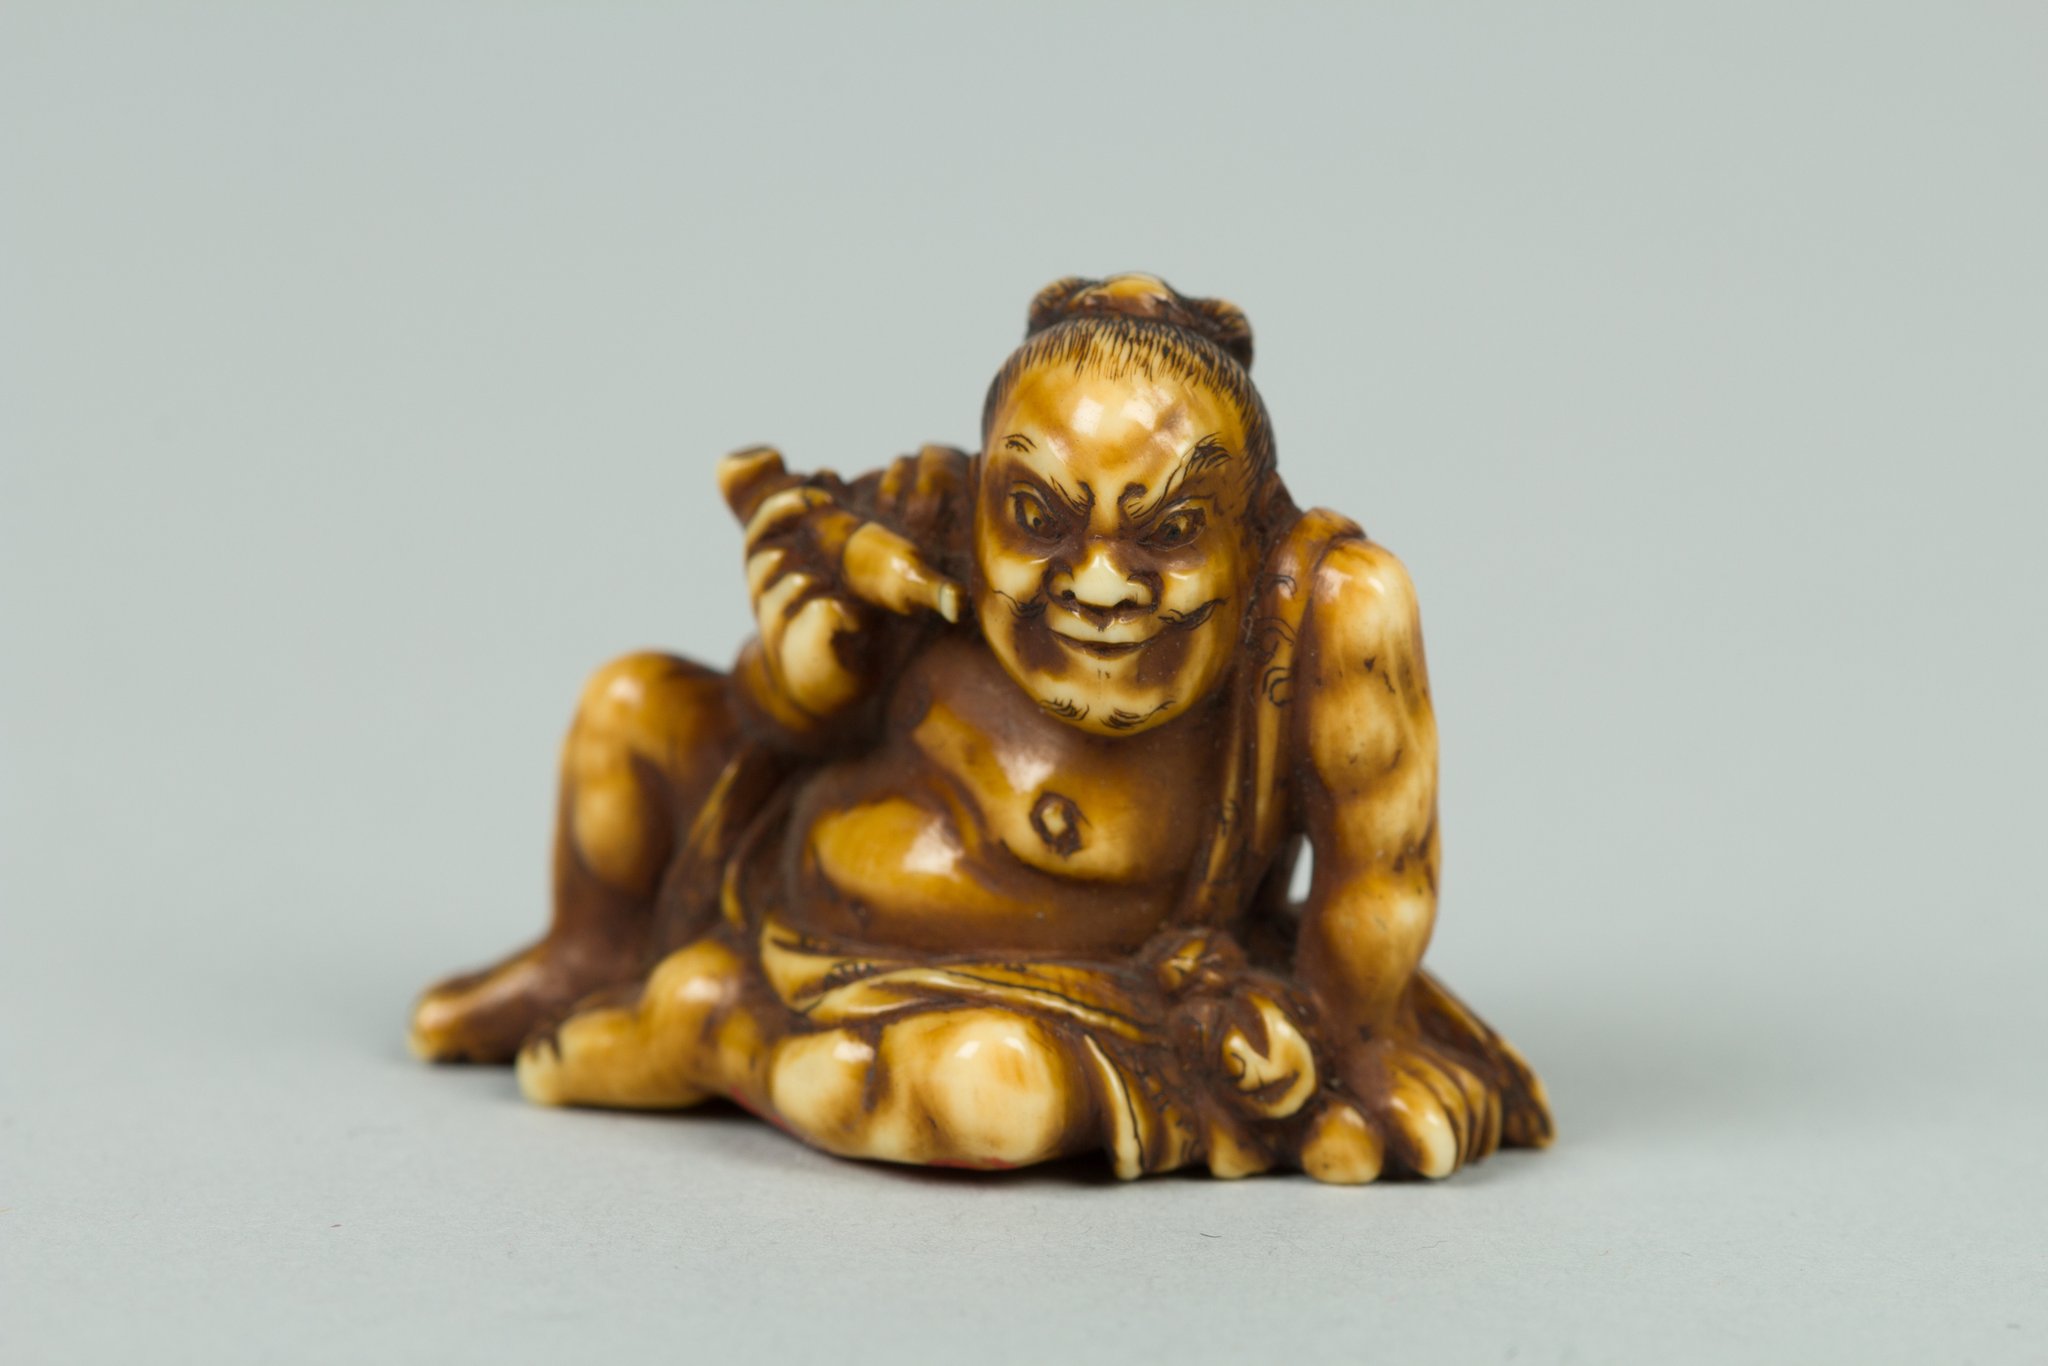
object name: netsuke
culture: japanese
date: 1801-1900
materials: ivory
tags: men